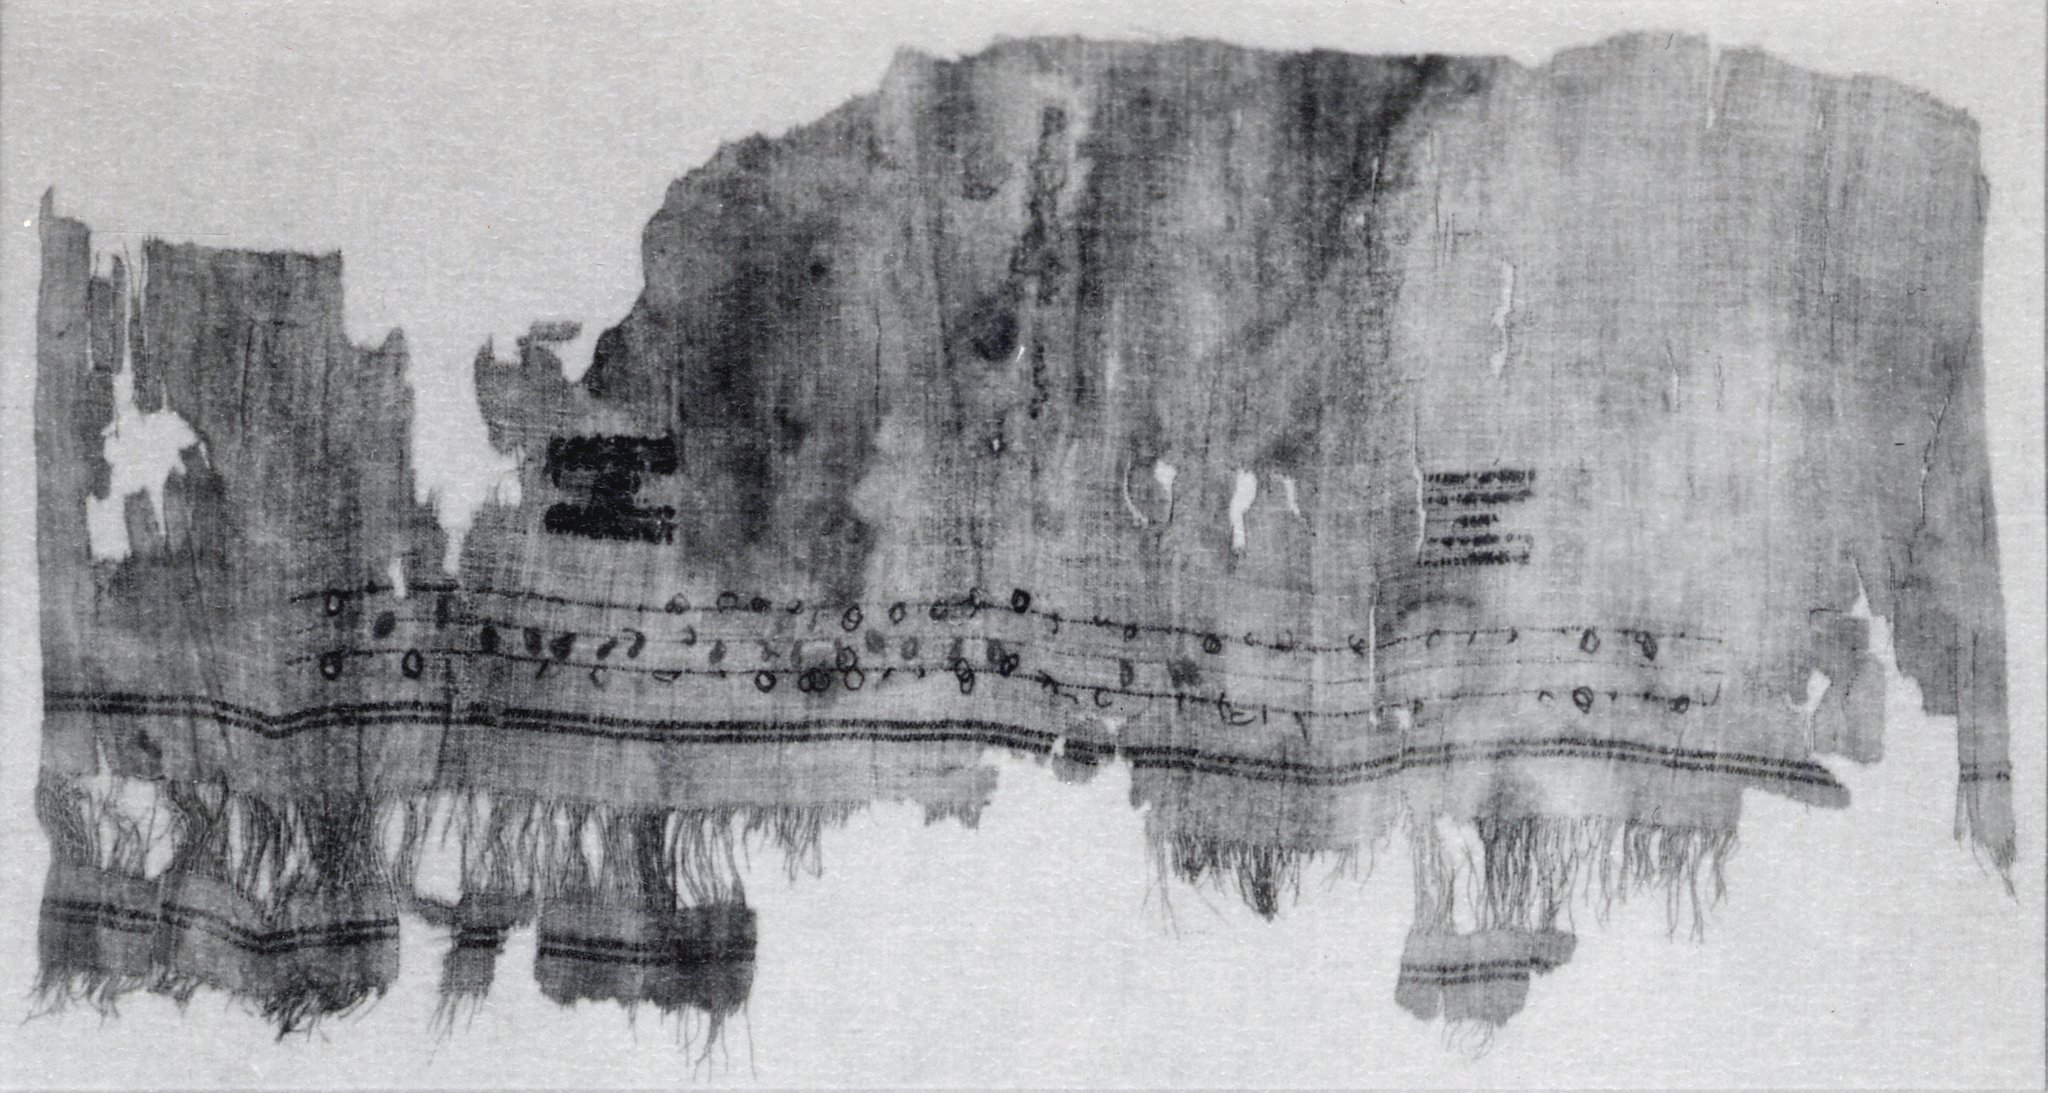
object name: fragment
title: Sheet Fragment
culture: coptic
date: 301-400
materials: linen, wool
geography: egypt